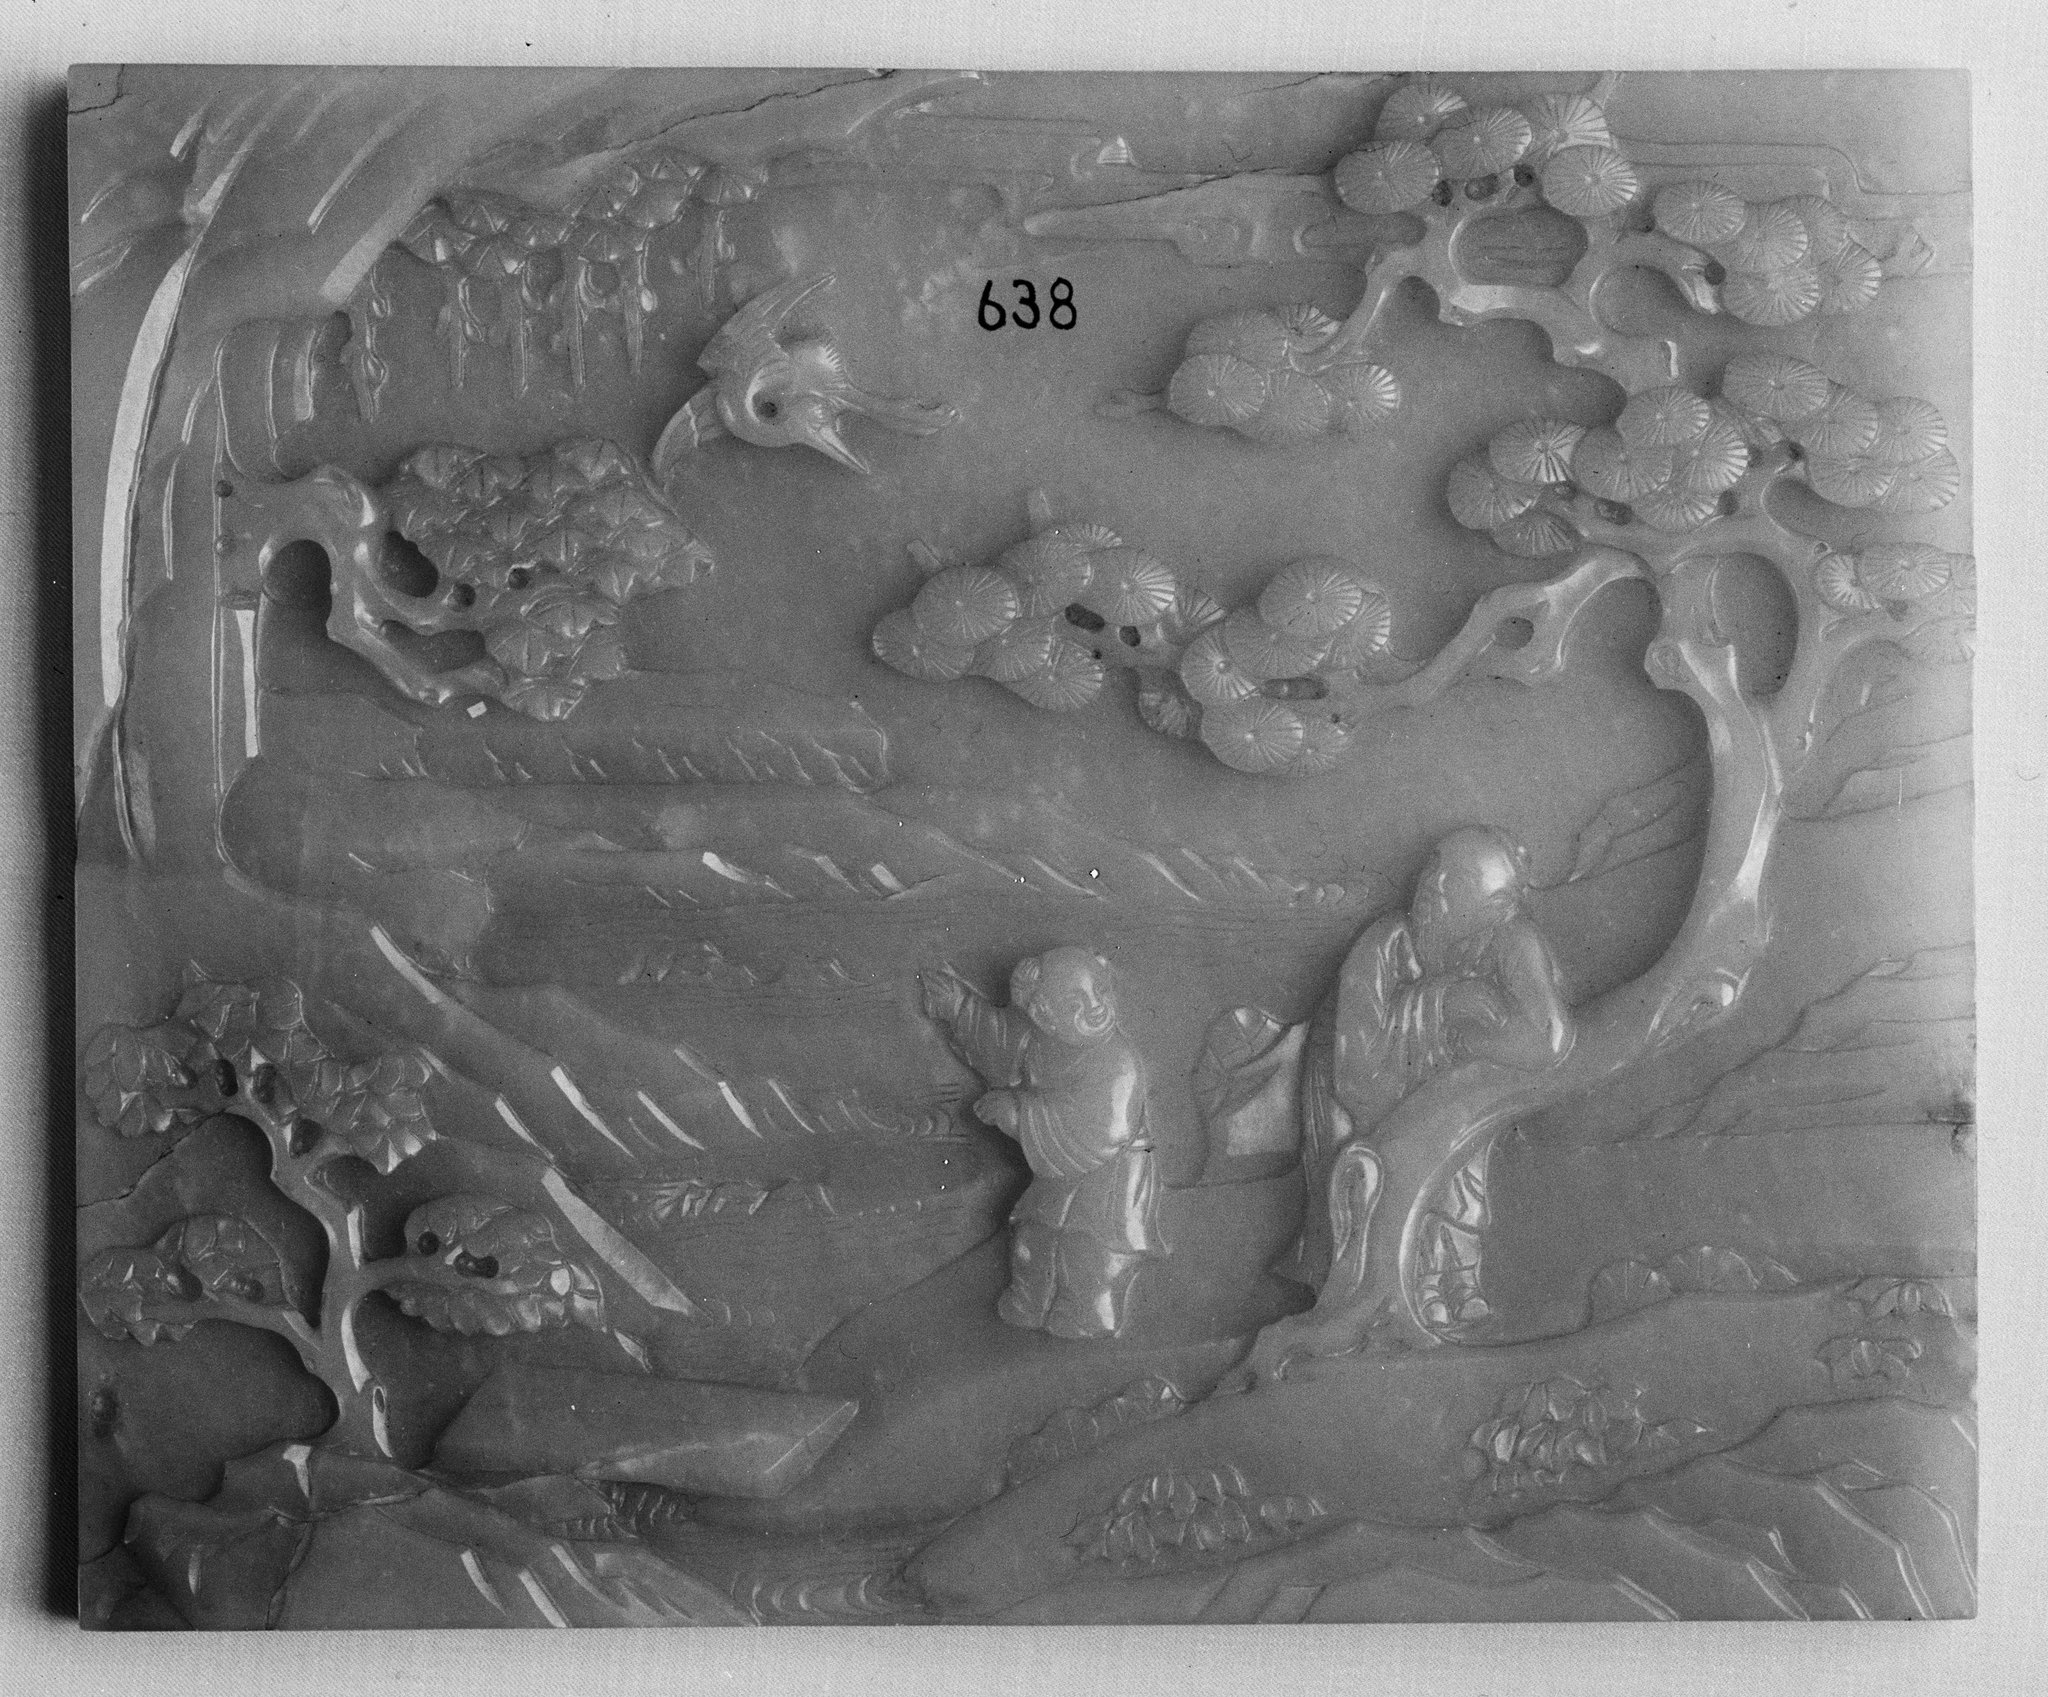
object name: table screen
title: Table screen with a scholar and a crane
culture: chinese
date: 1736-1795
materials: jade